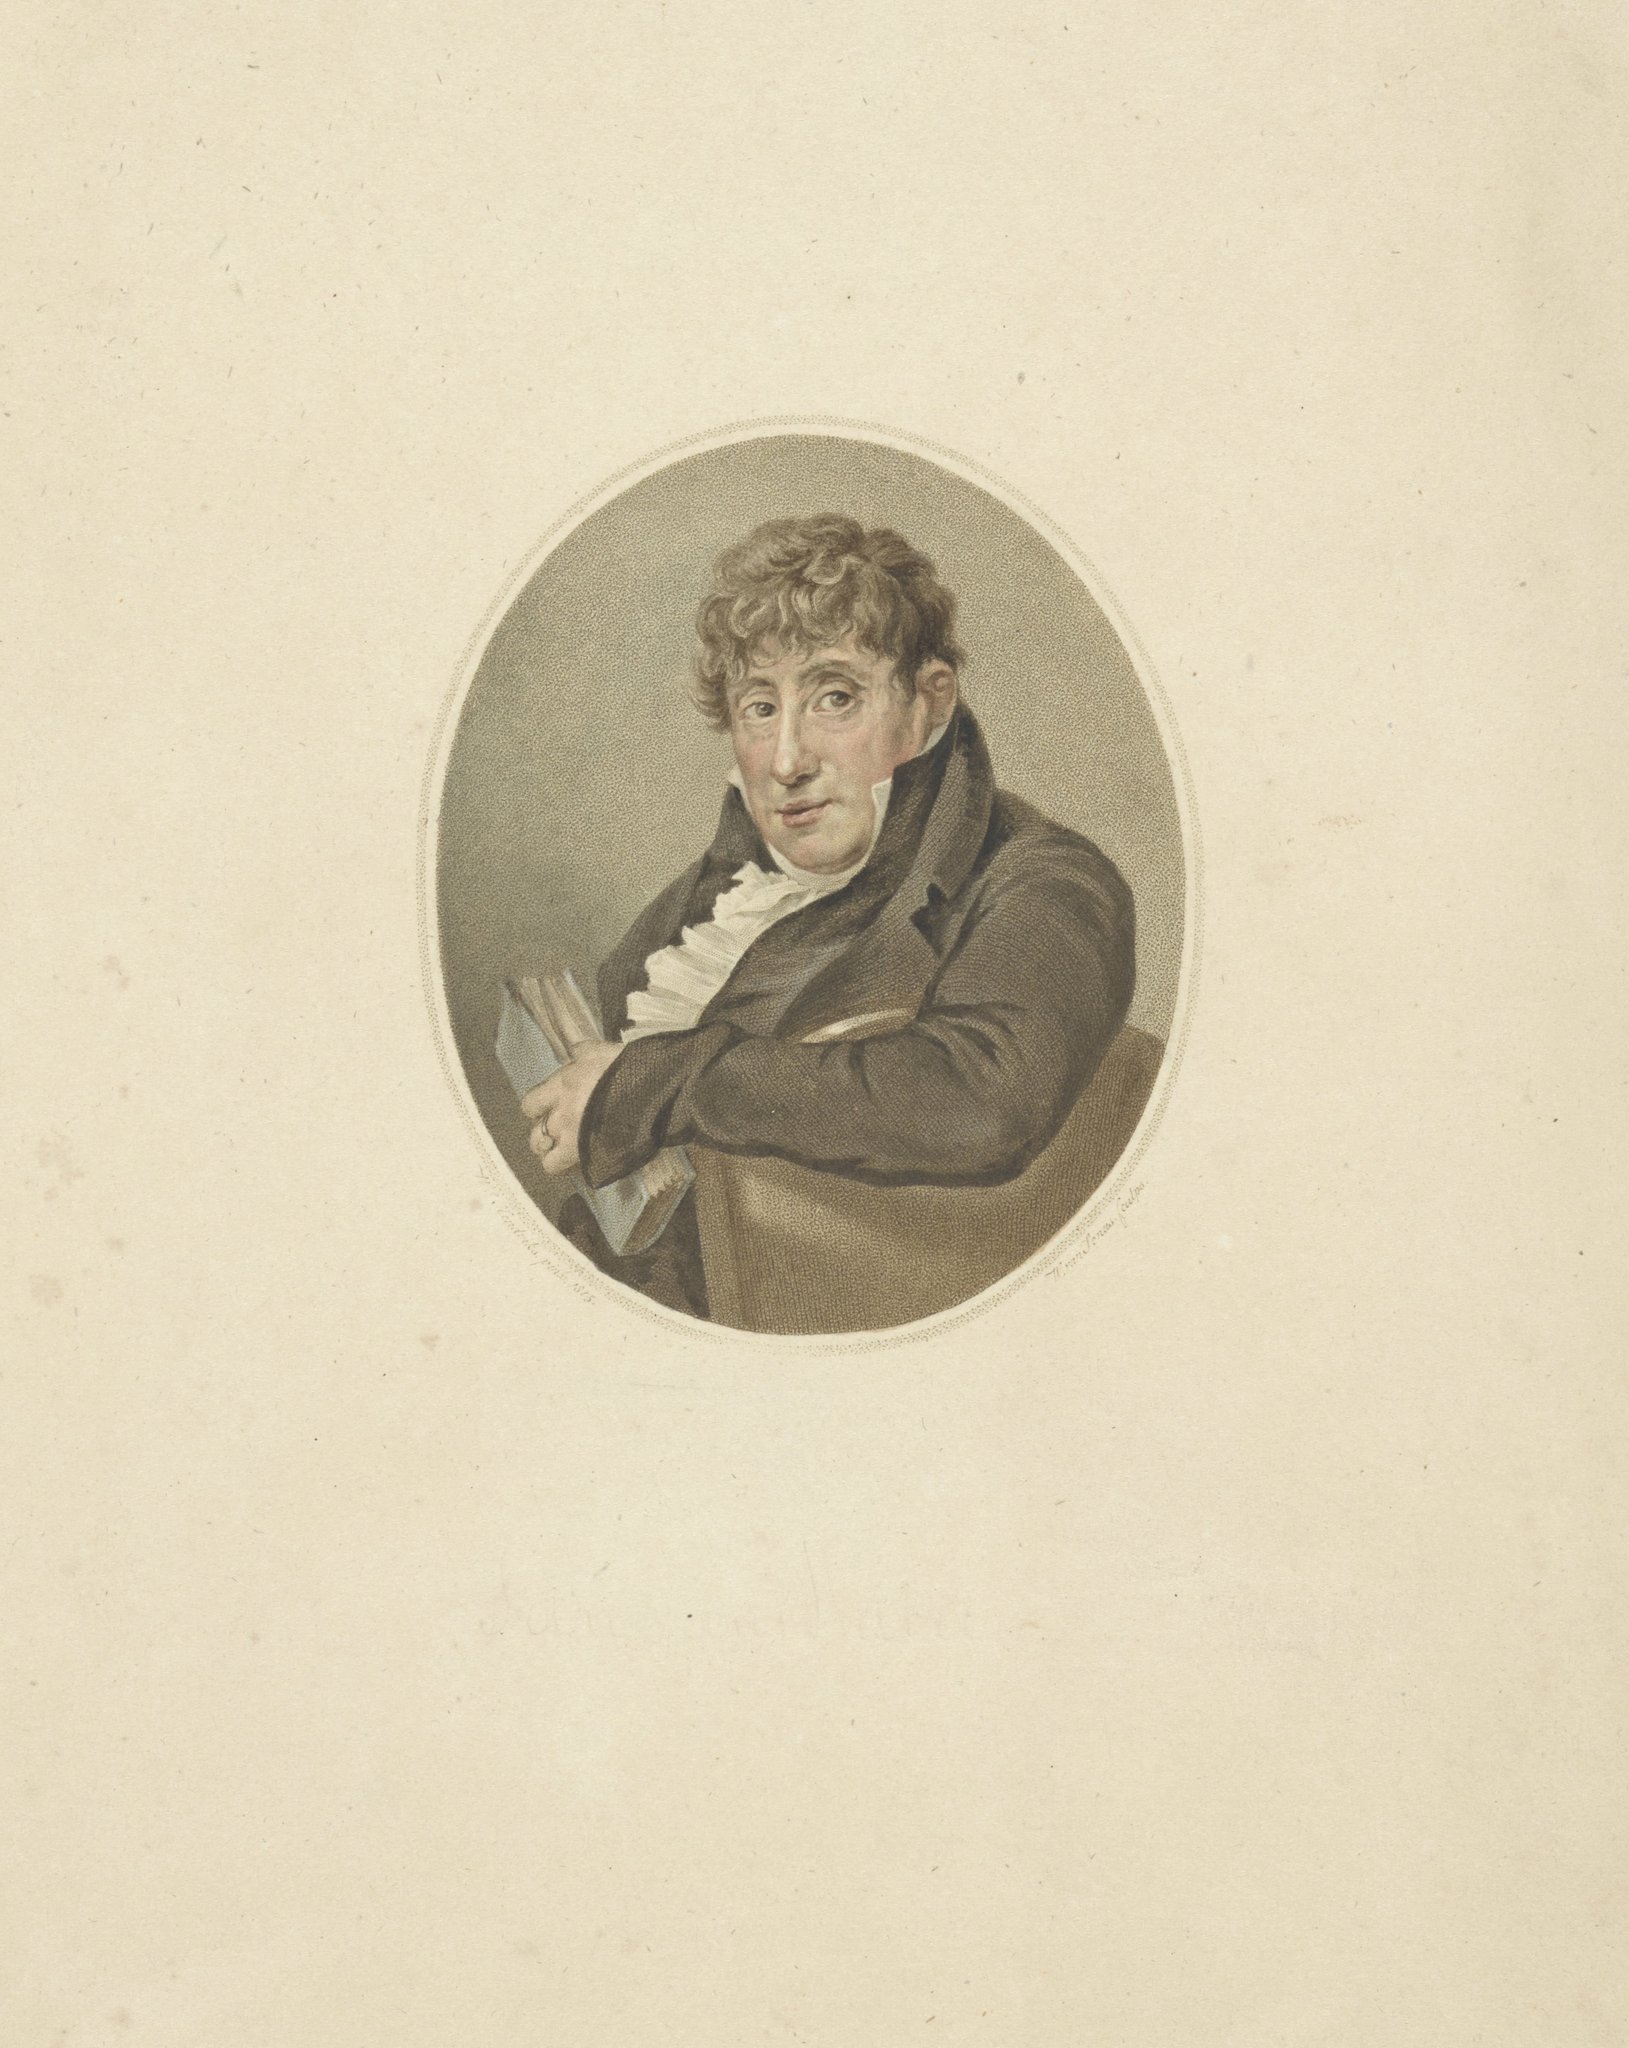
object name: print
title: Portret van Jan van Walré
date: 1815-1851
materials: paper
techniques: brush, etching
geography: netherlands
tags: haarlem, publisher, jan van walré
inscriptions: collector's mark: Lugt 2228, collector's mark: Lugt 2760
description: Portret van de Haarlemse schrijver en uitgever Jan van Walré.